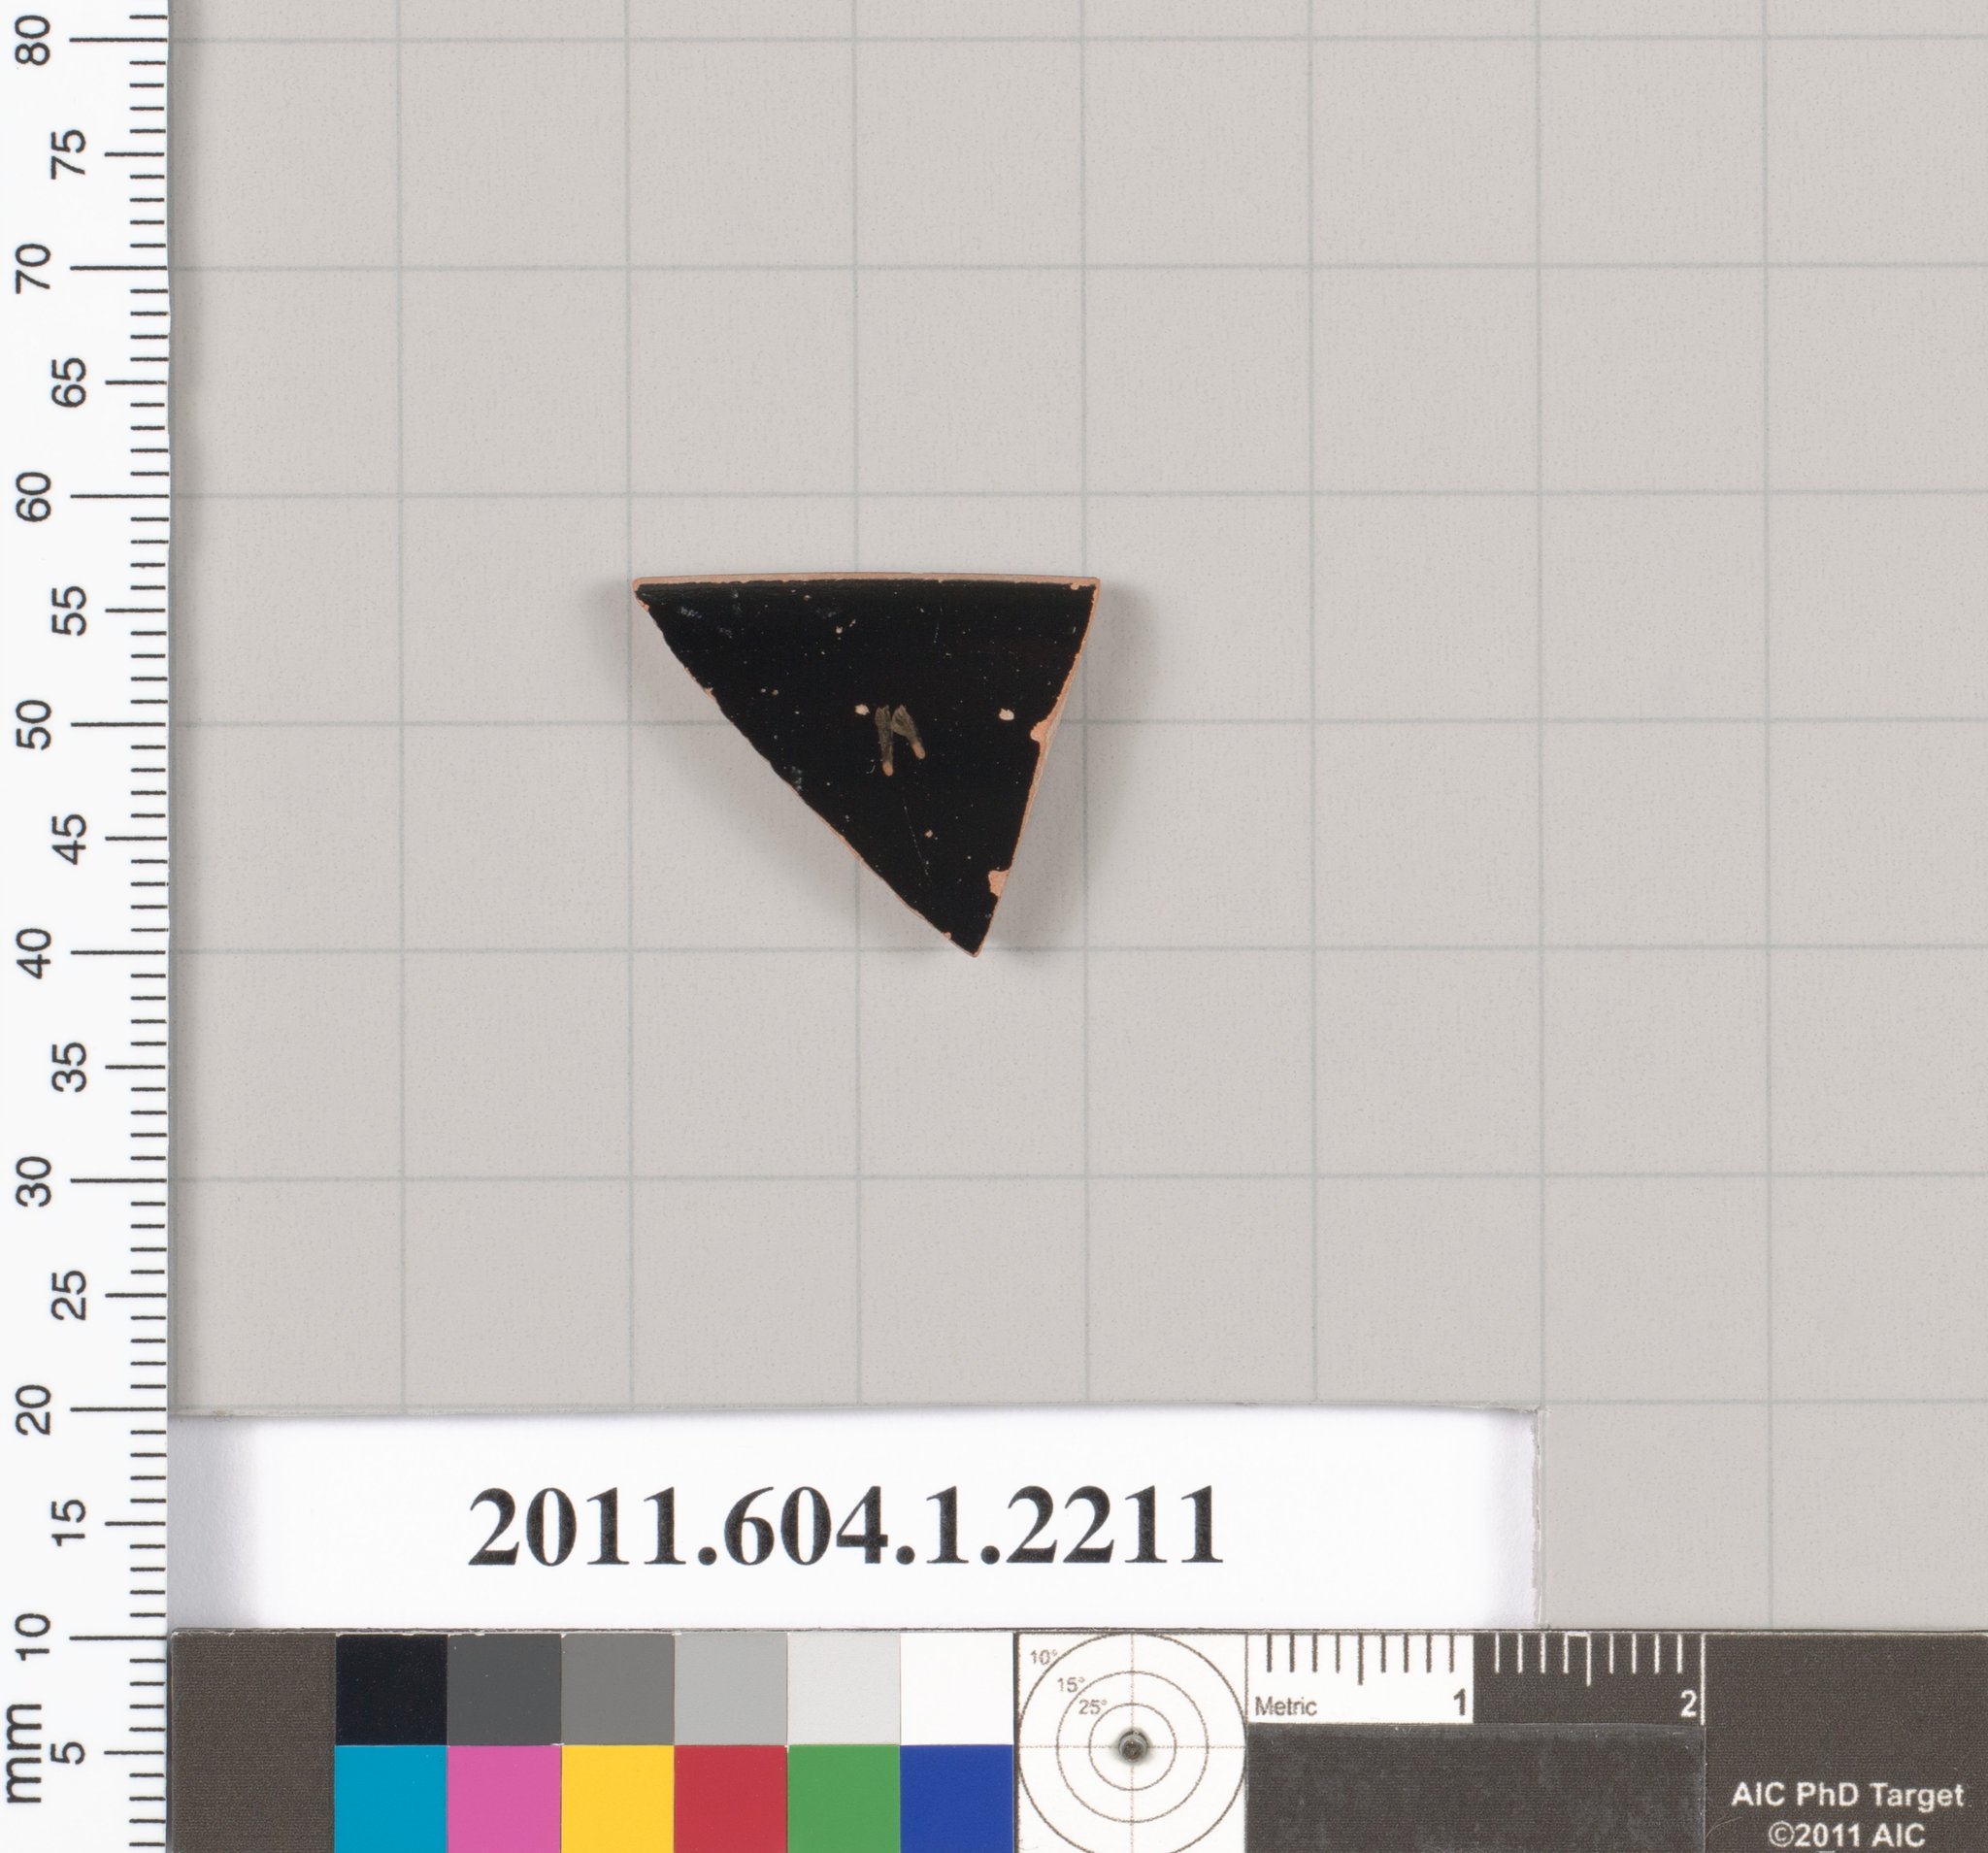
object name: kylix fragment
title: Terracotta rim fragment of a kylix (drinking cup)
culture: greek, attic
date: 500-451 BCE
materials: terracotta